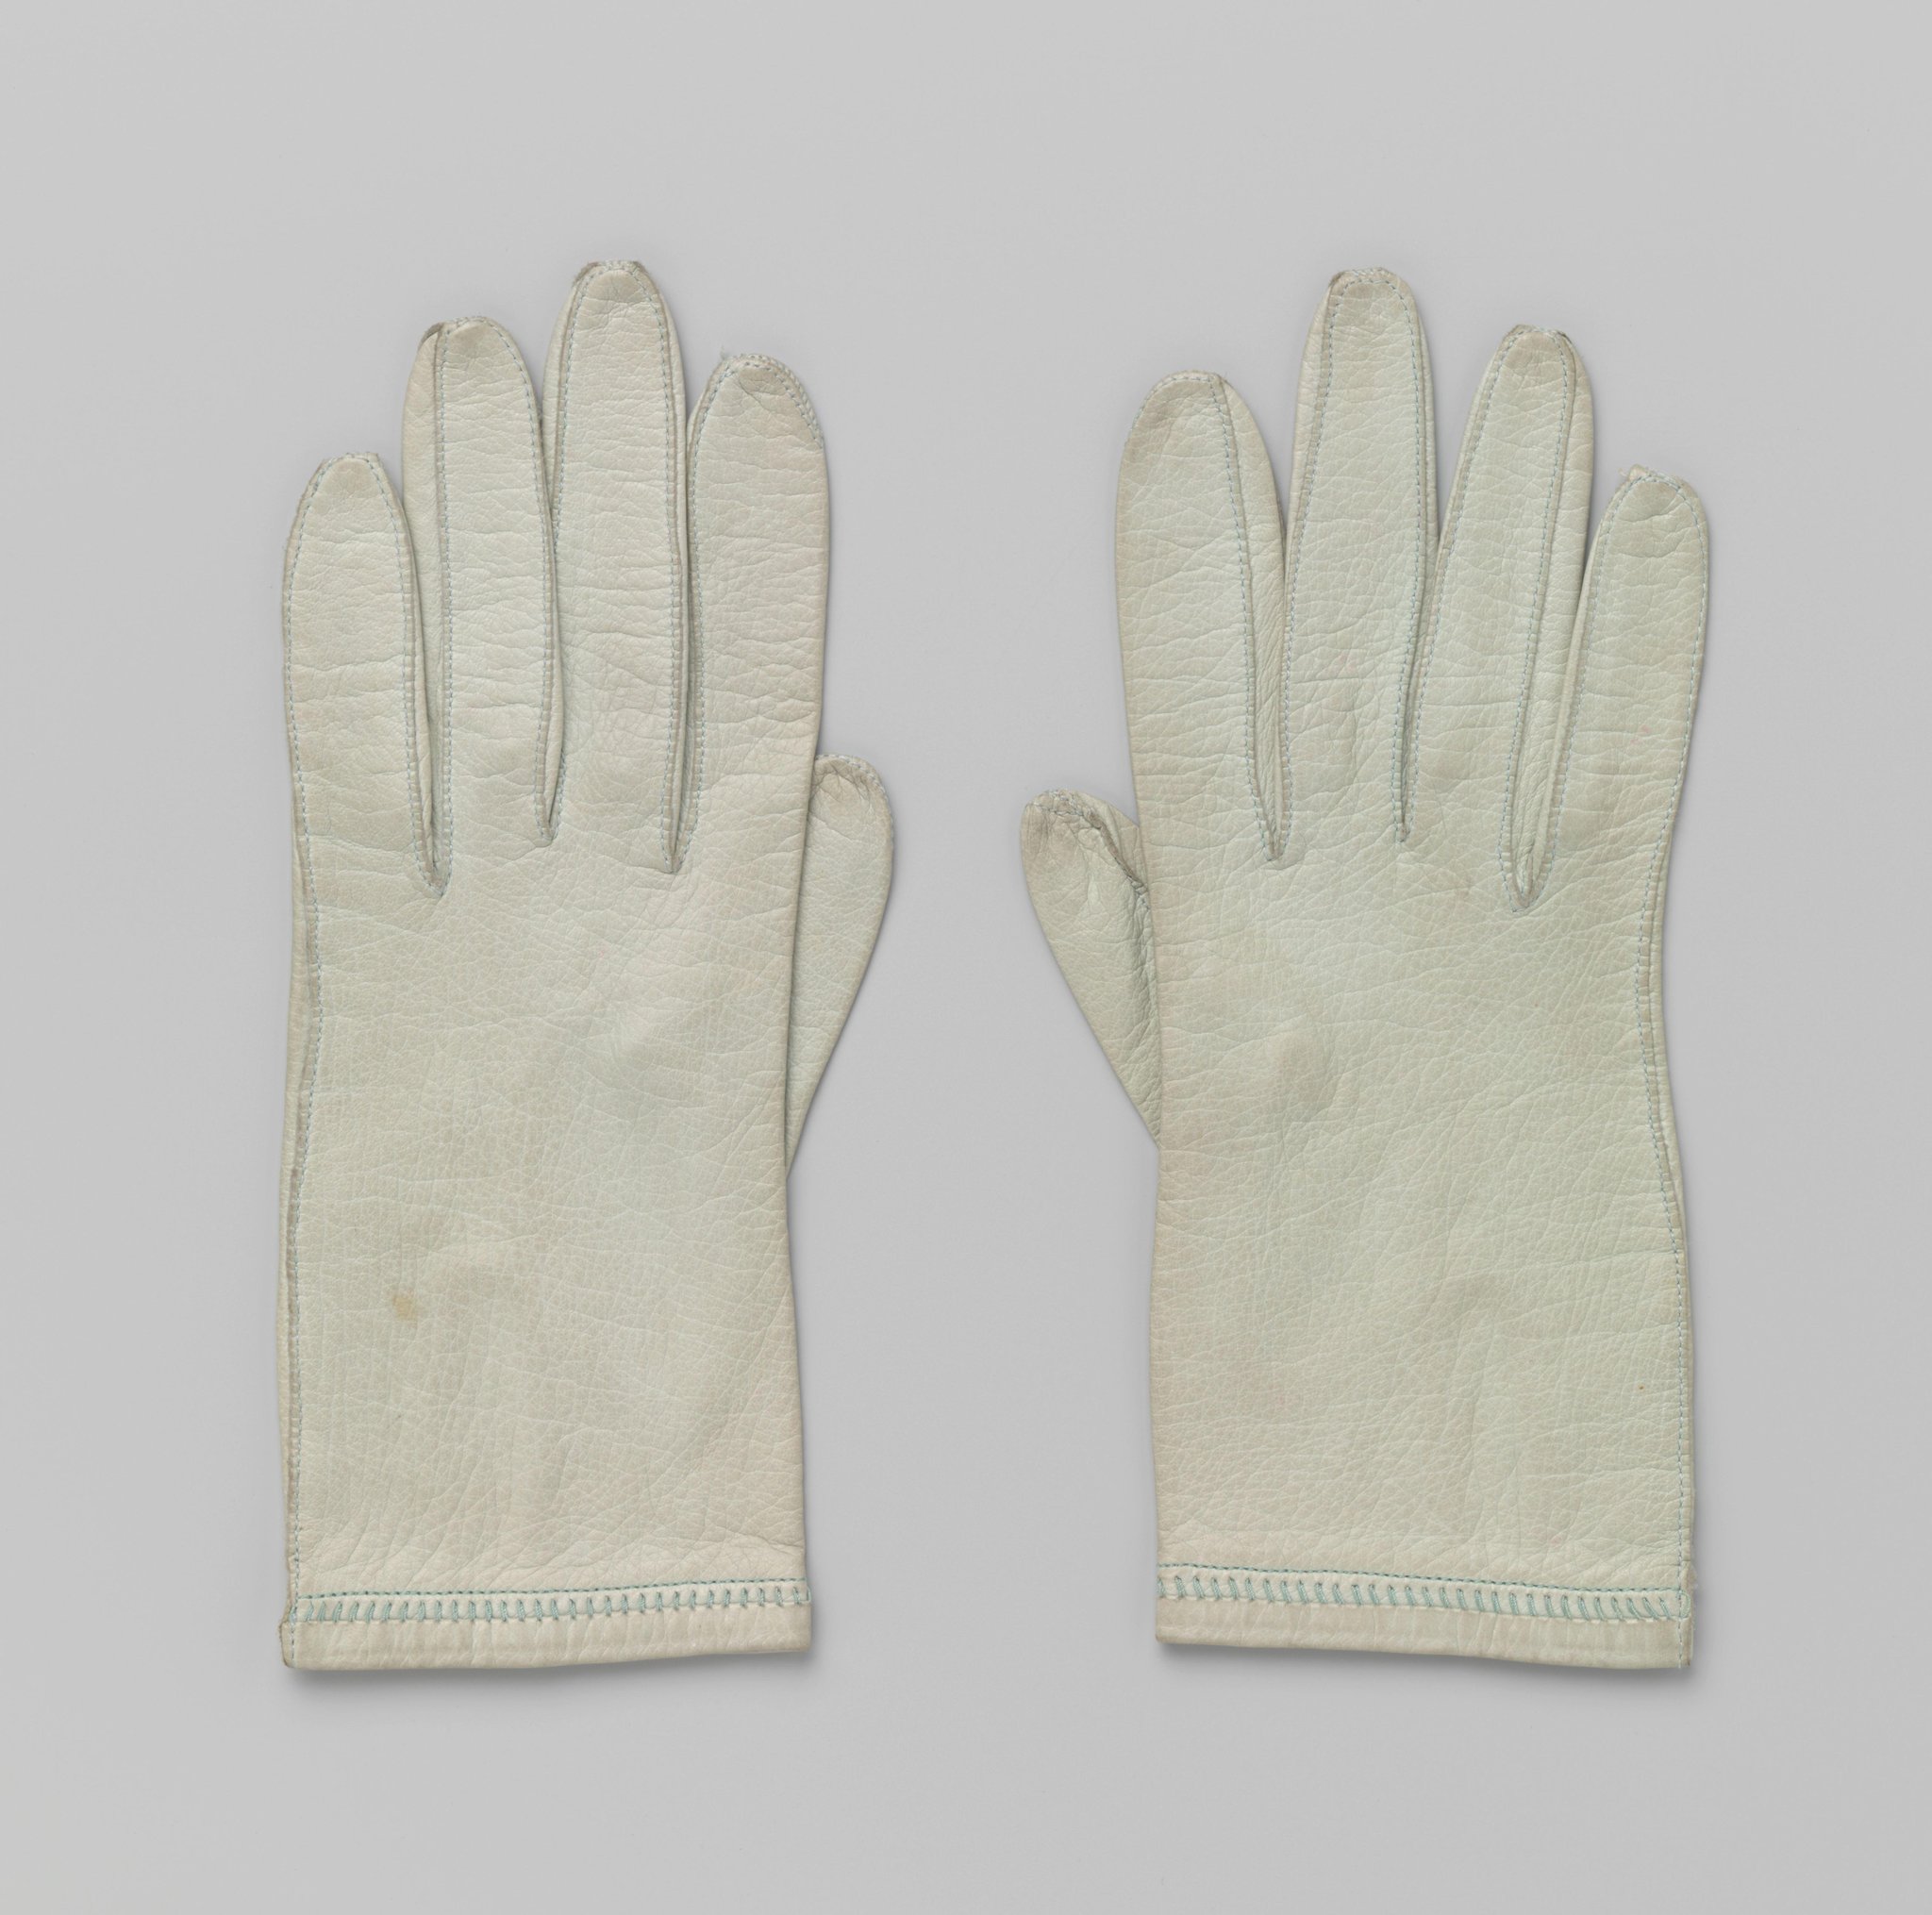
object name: glove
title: Pair of gloves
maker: Anonymous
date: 1910-1920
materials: leather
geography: france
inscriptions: stamp: ‘cijfers en letters’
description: Linker handschoen van leer in mintgroene kleur.